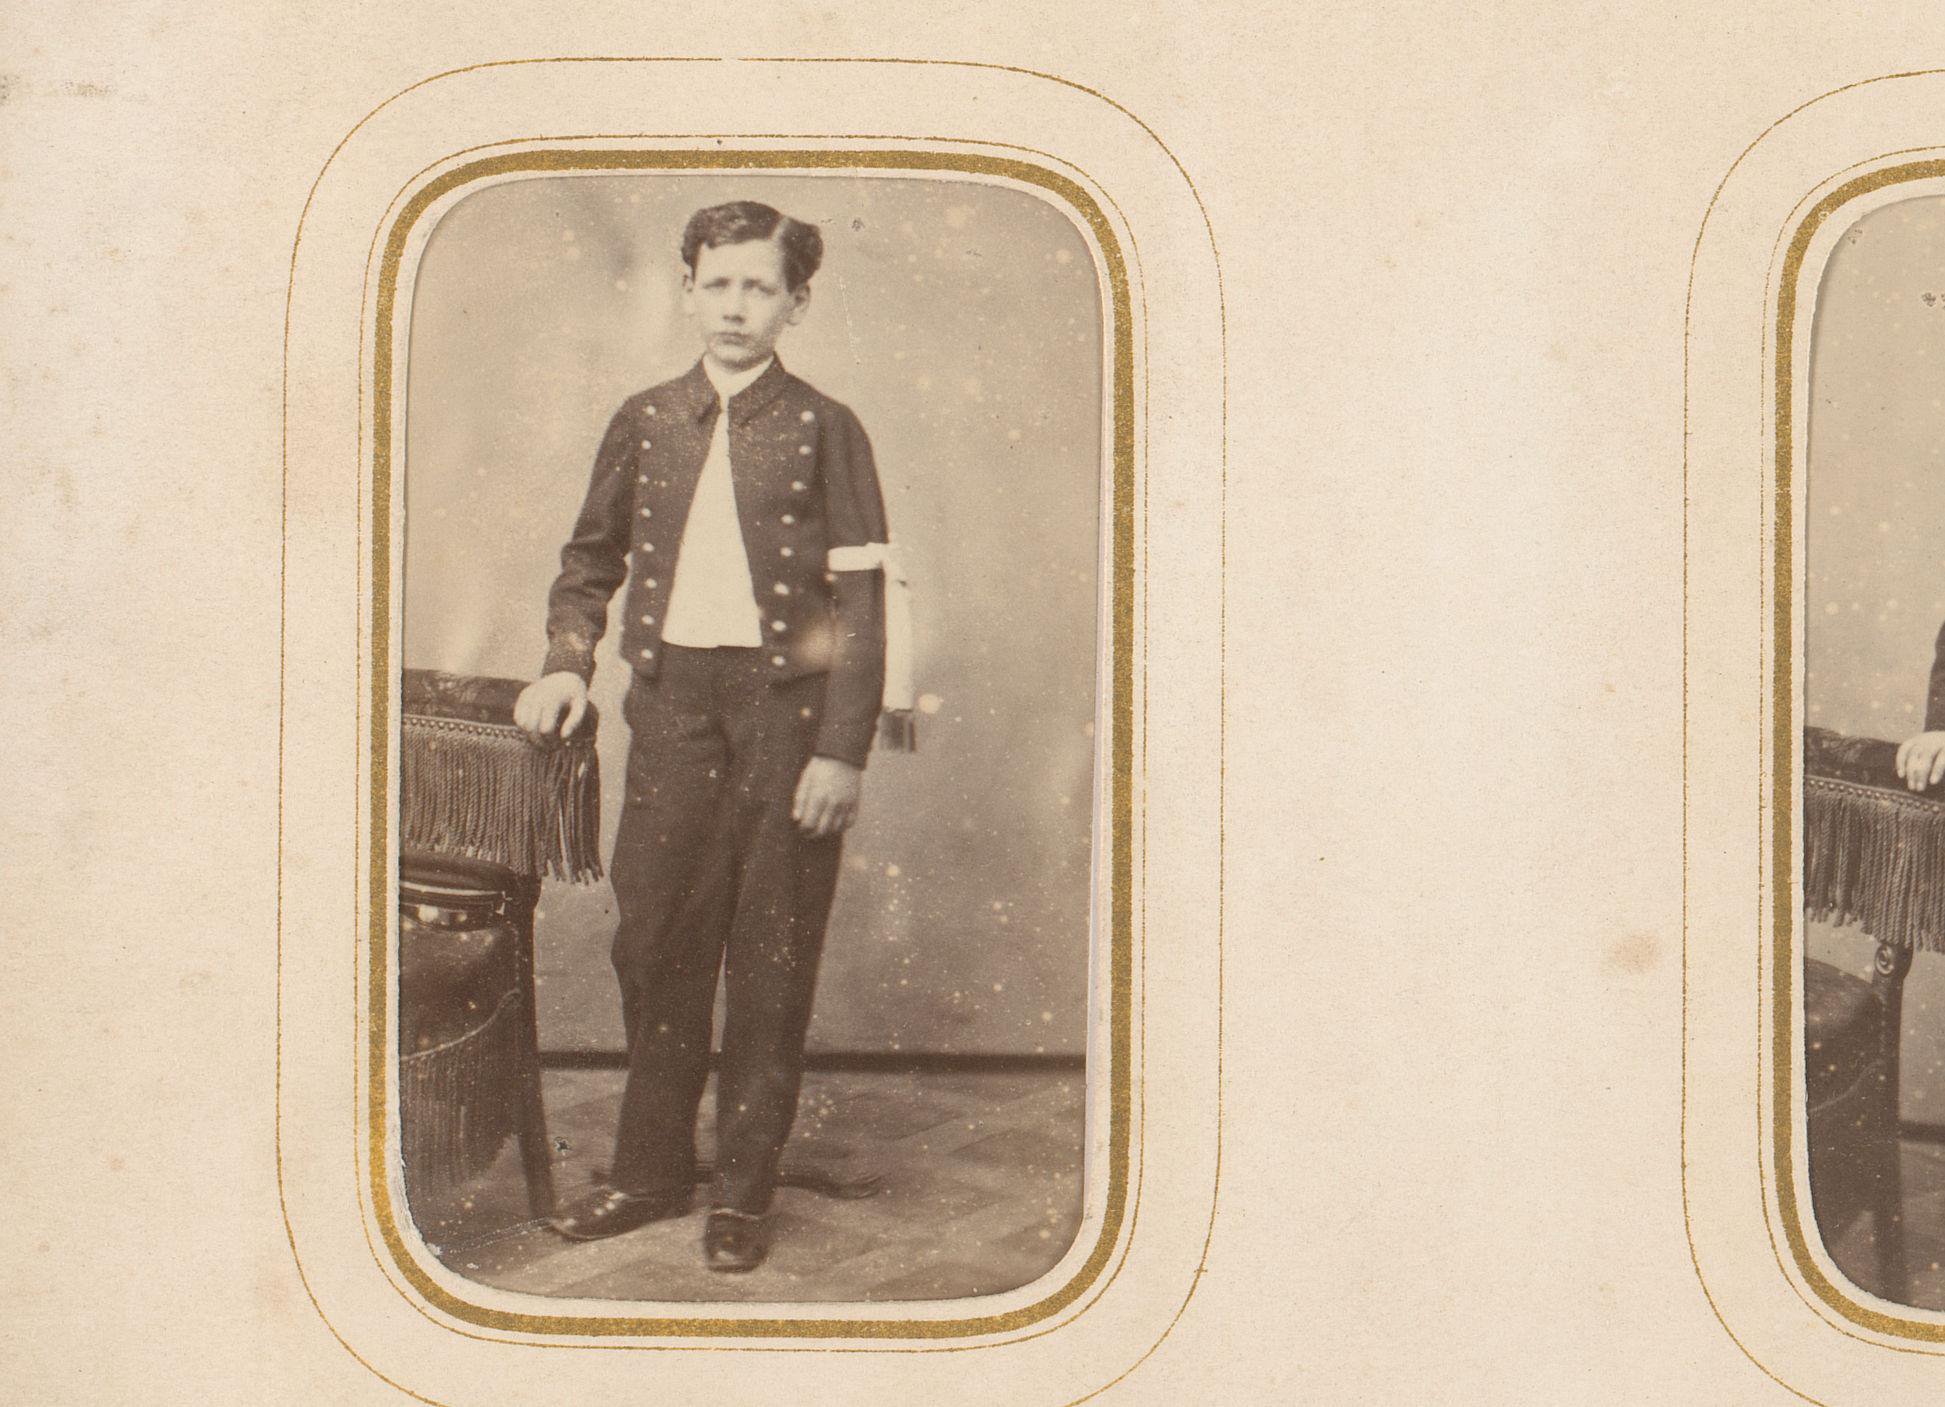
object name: carte de visite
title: Portret van een staande jongen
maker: a. loisel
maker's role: fotograaf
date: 1860-1890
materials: cardboard, photographic support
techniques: albumen print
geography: paris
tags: boy (child between toddler and youth)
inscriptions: inscription: ‘A. Loisel, Phot.’, inscription: ‘Photographie du XIX siècle/ A. Loisel/ 50, Boulevard de Strasbourg, 50/ Passage du Désir/ Paris’